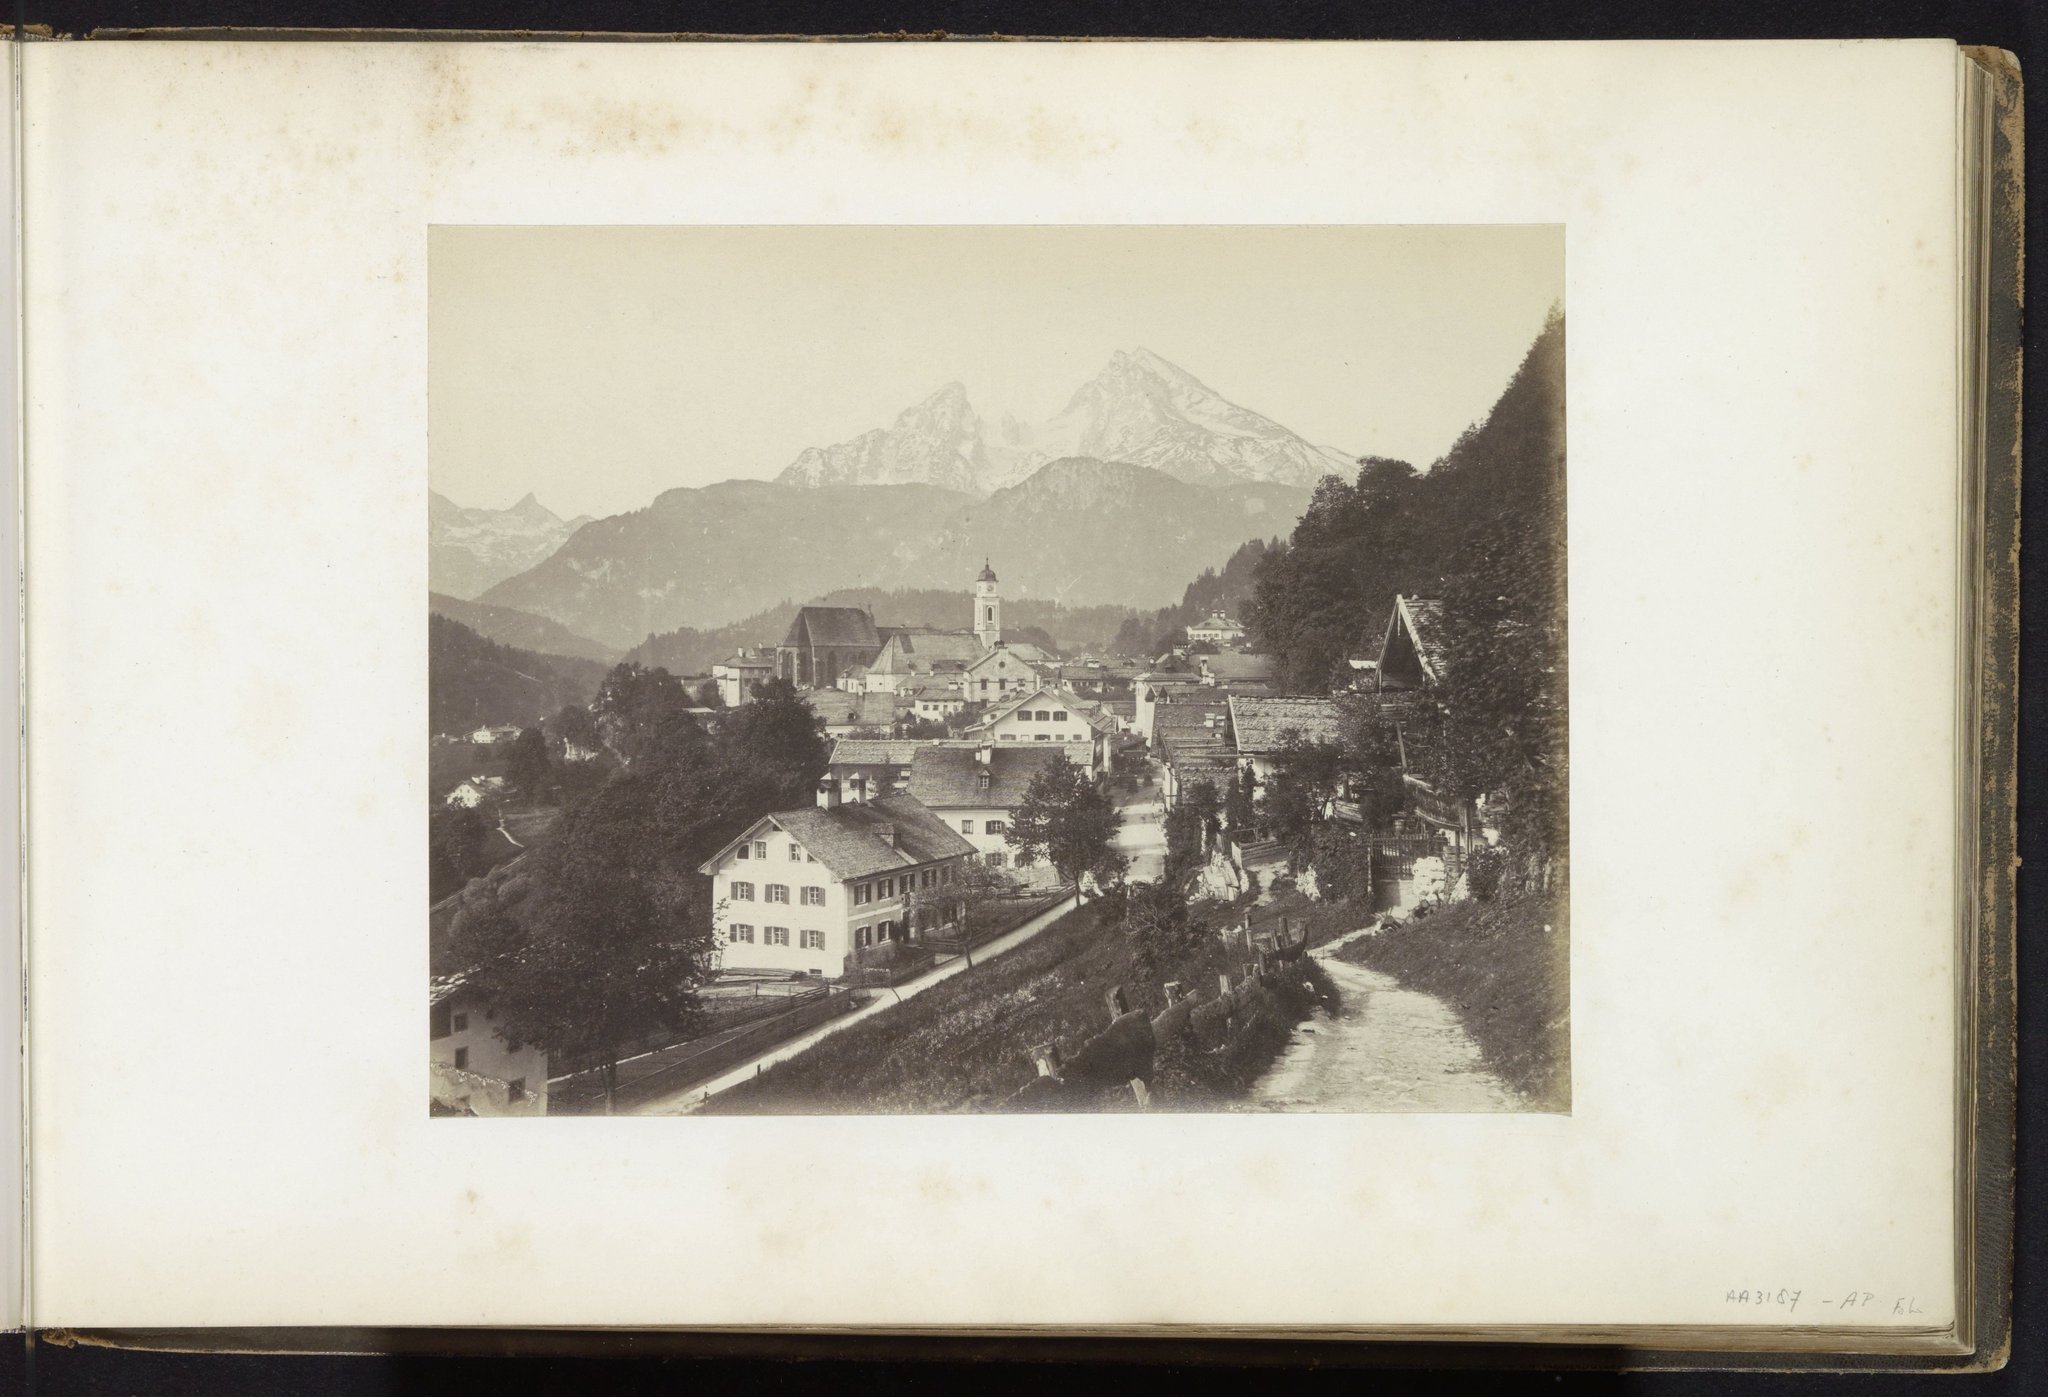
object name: photograph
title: Gezicht op een bergdorp, vermoedelijk in de Alpen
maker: Anonymous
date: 1865-1875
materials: paper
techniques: albumen print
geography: alps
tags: prospect of village, silhouette of village, mountains (+ landscape with figures, staffage)